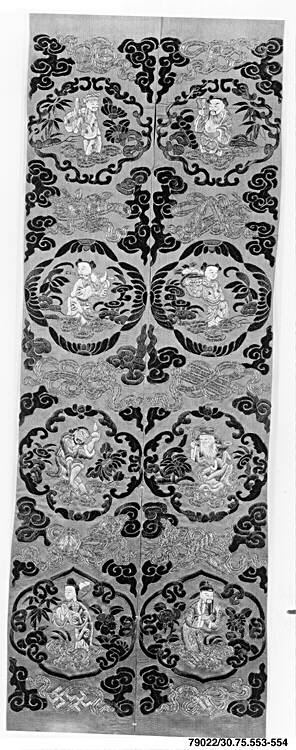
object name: sleeve band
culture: chinese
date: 1801-1900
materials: metal thread, silk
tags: human figures